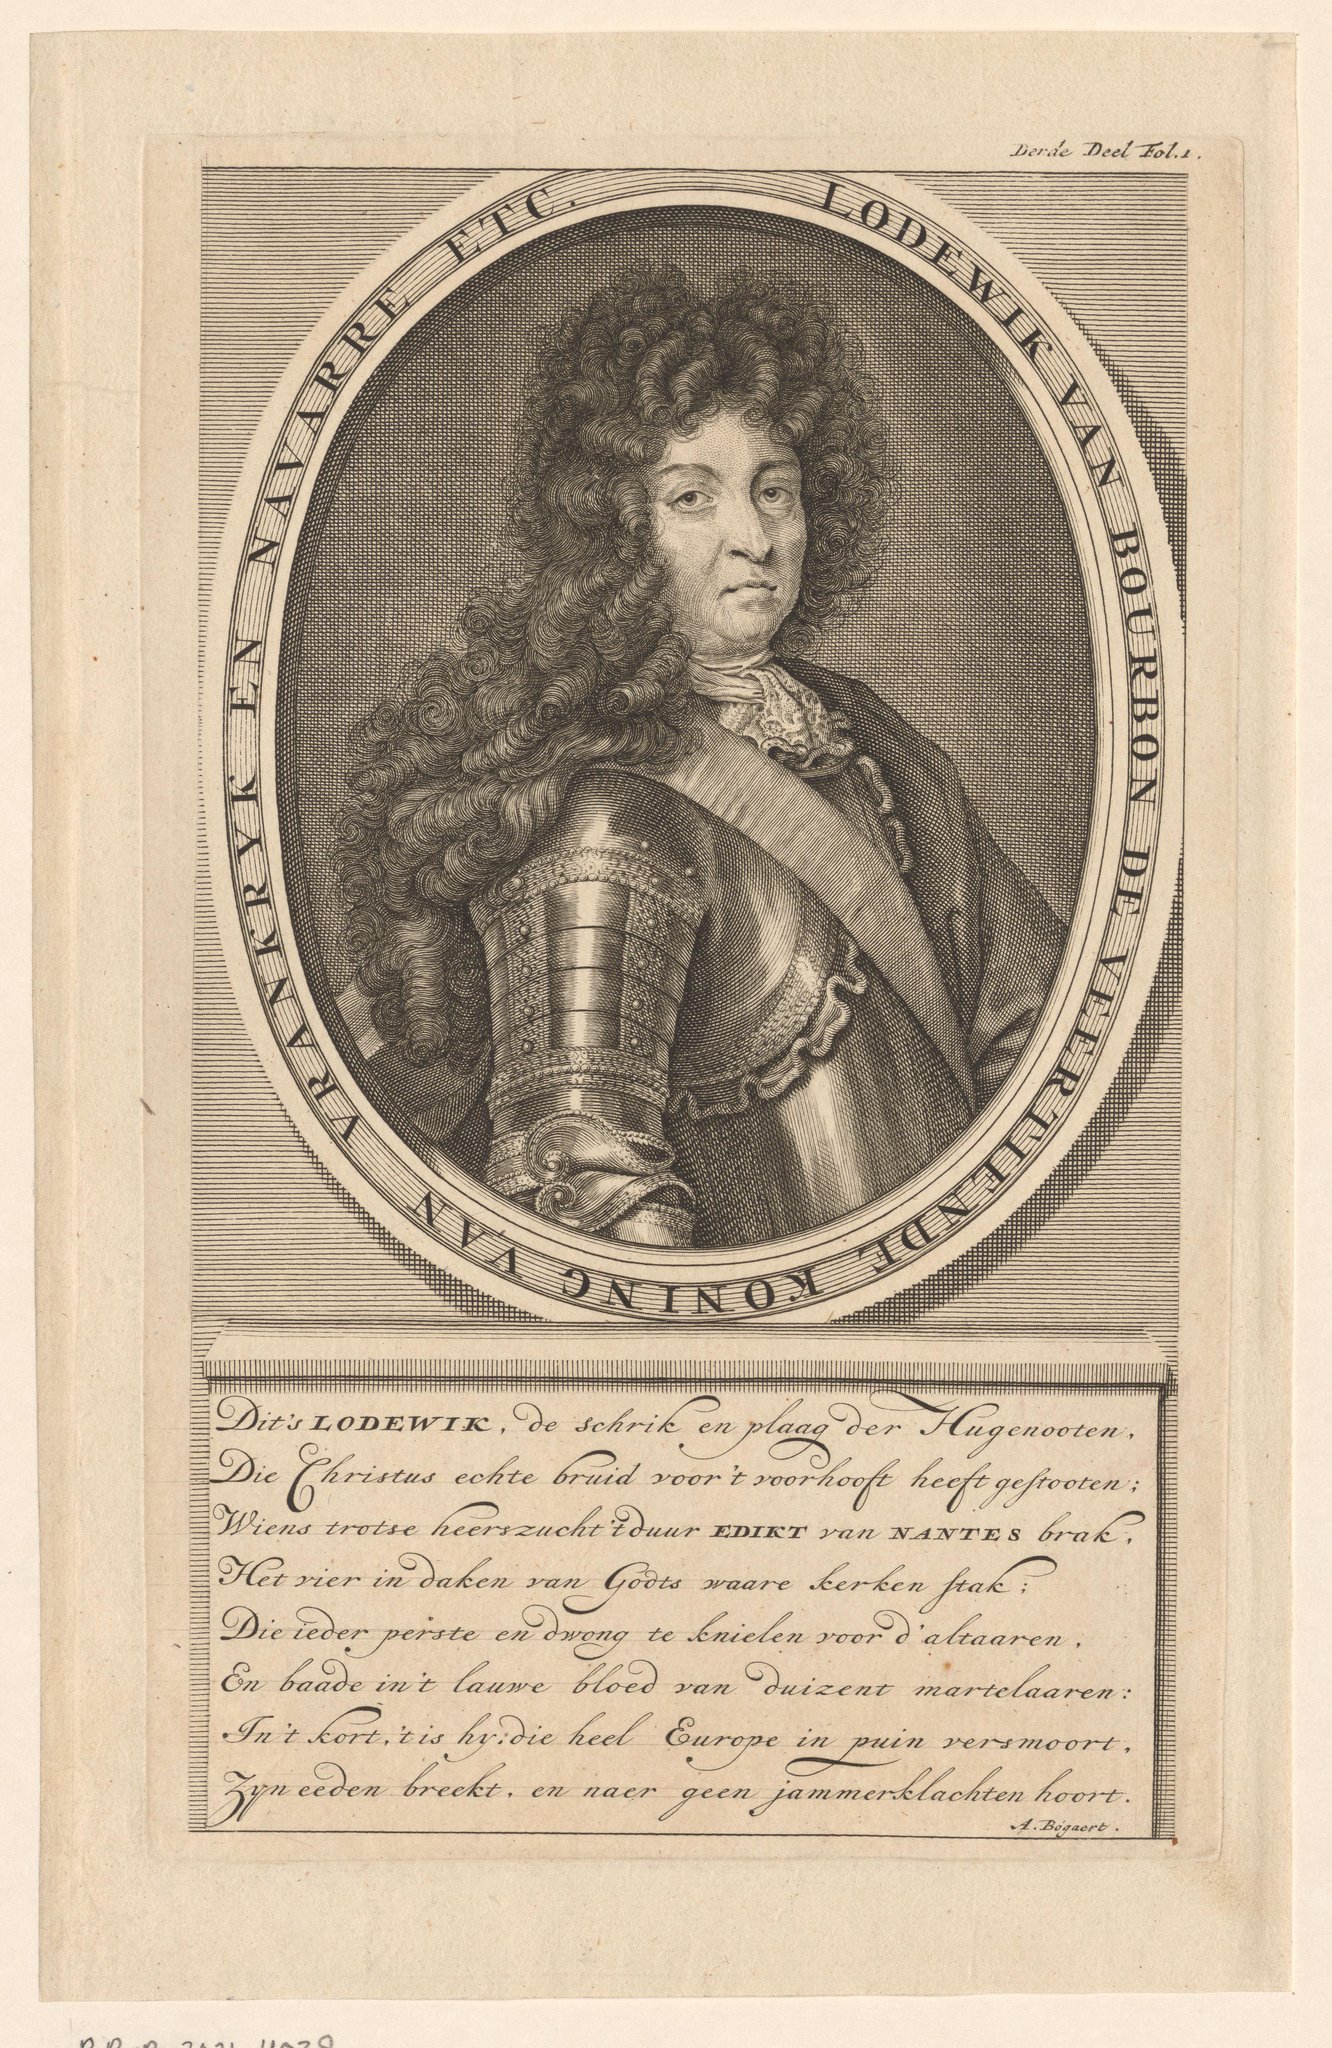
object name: print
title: Portret van Lodewijk XIV van Frankrijk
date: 1680-1727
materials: paper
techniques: engraving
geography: northern netherlands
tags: lodewijk xiv (koning van frankrijk), ornament ~ medallion, armour, historical persons, king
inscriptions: collector's mark: Lugt 240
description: Rechtsboven: Derde Deel Fol. 1. Met achtregelig vers in het Nederlands onder het portret.